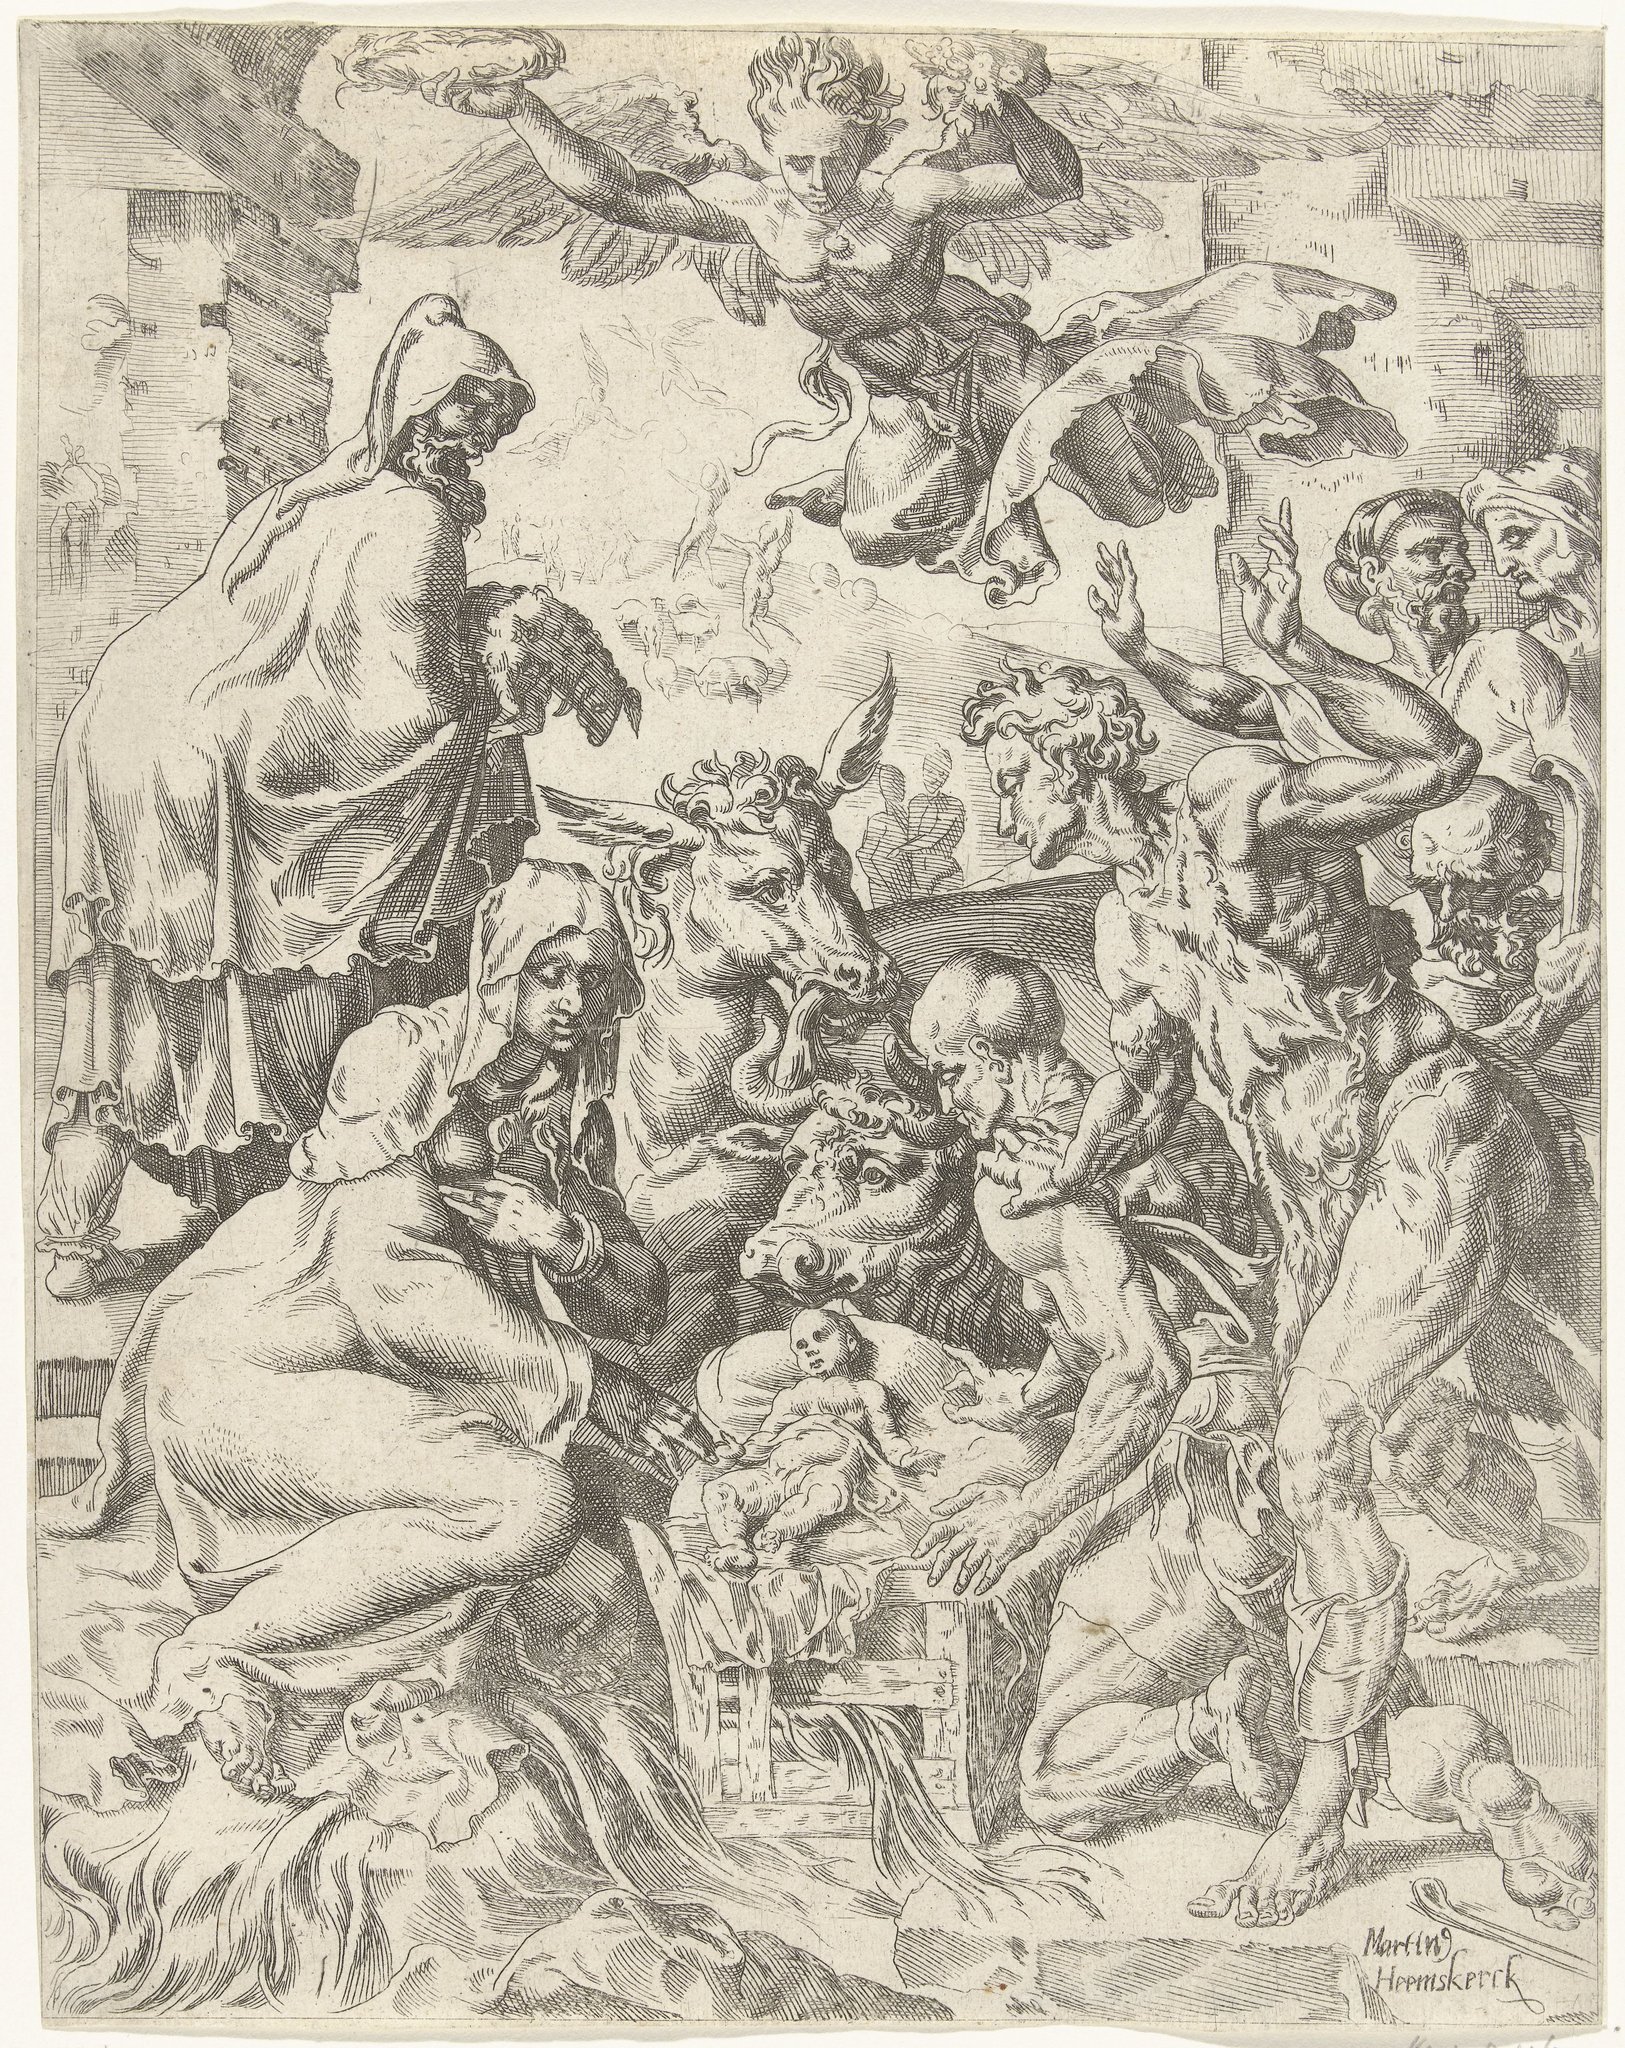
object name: print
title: Aanbidding der herders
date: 1548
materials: paper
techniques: etching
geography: haarlem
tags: adoration of the christ-child by the shepherds; mary and joseph present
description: Maria en Jozef zitten geknield voor de kribbe. Herders komen het Christuskind aanschouwen. Boven de kribbe vliegt een engel met een lauwerkrans. De prent is deel van een dertigdelige serie met prenten over de zondeval en Christus' passie.